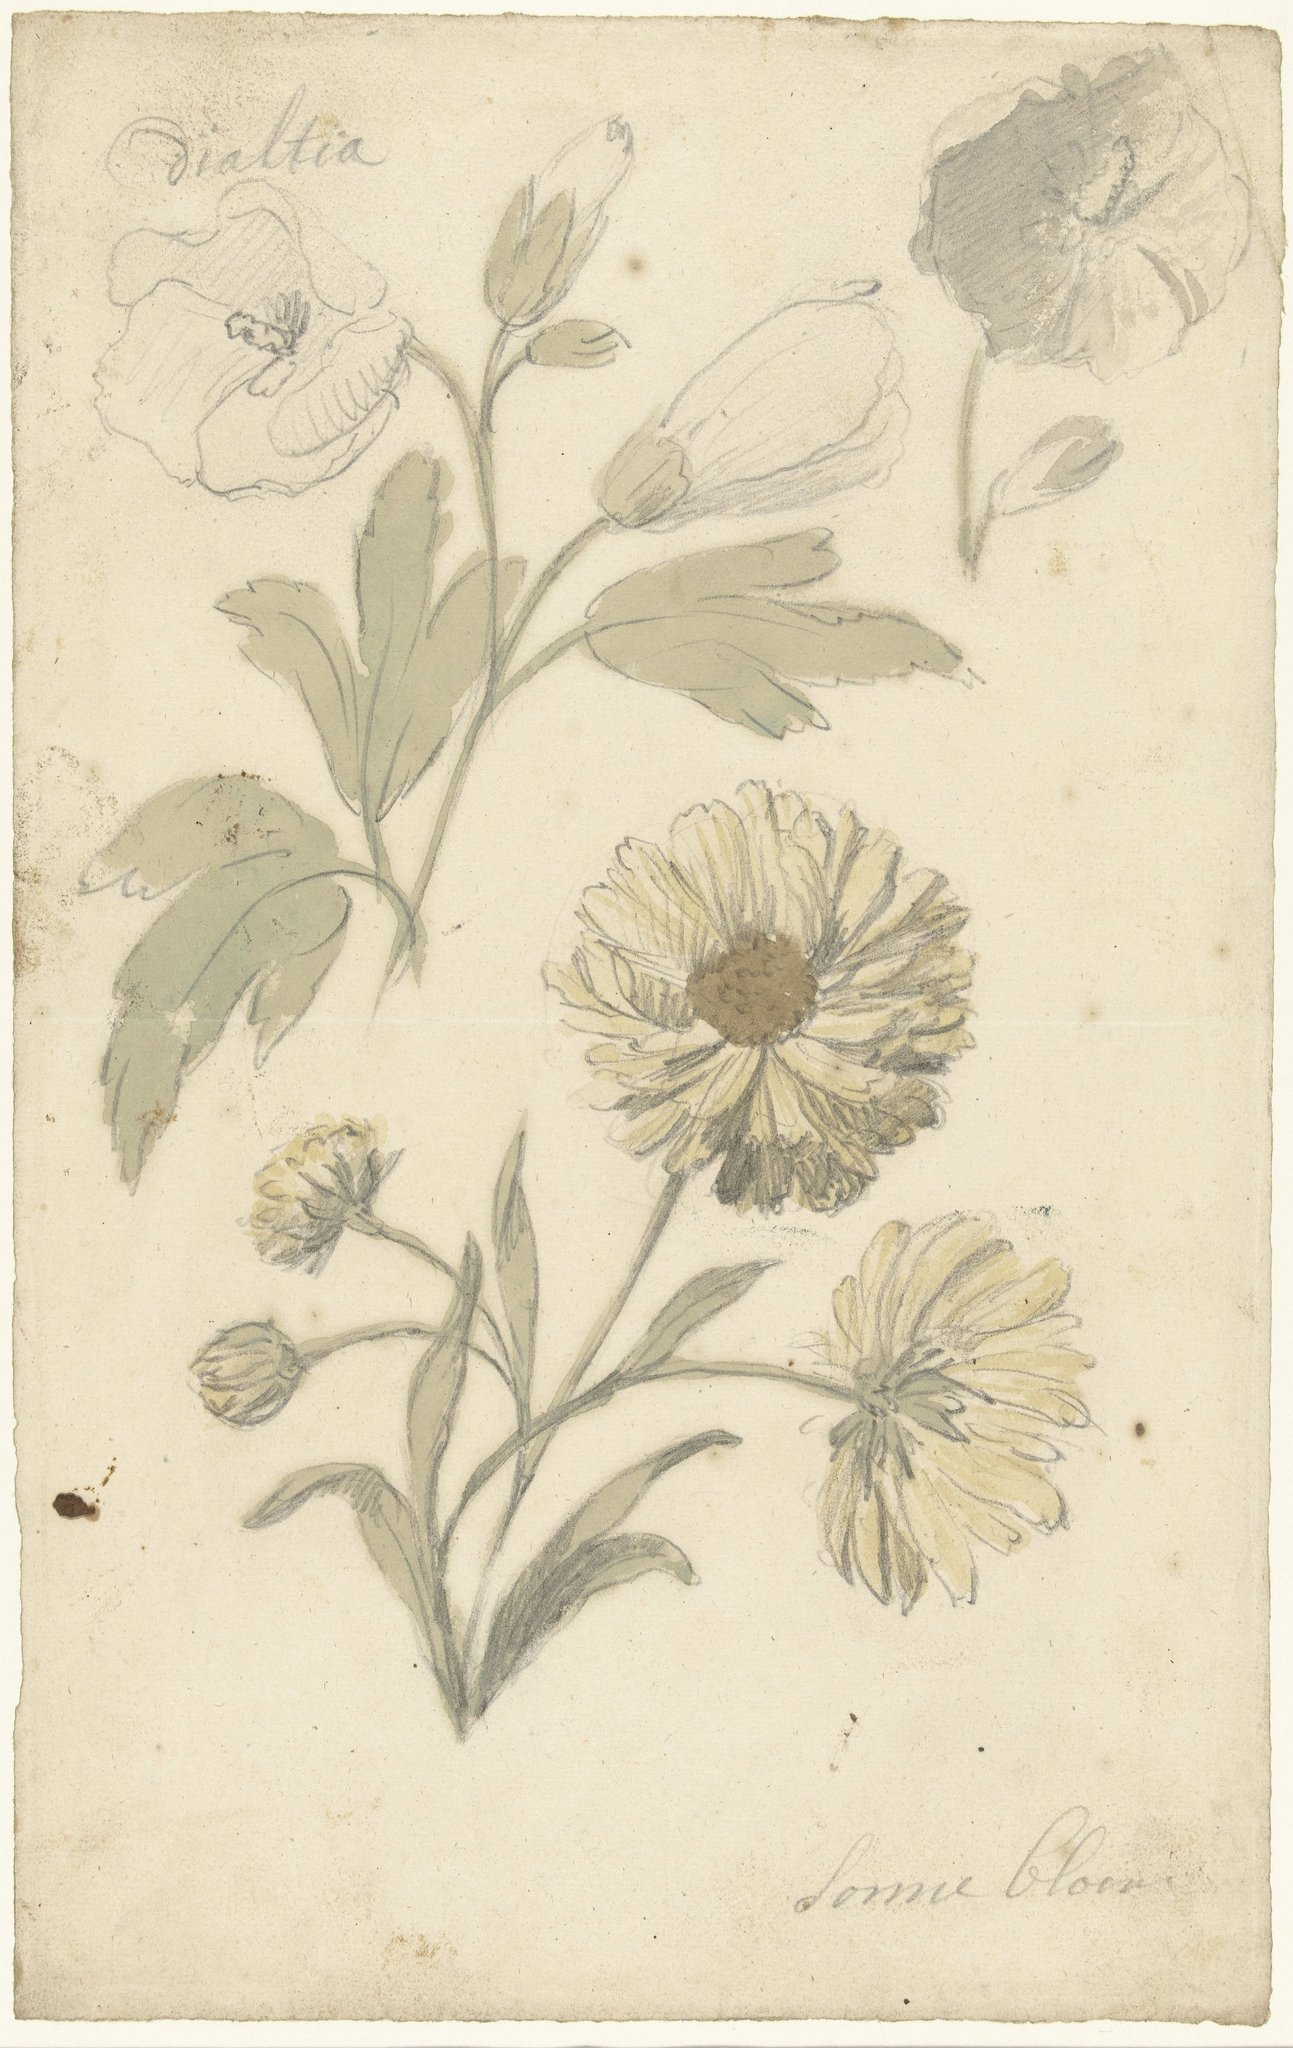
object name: watercolor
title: Studies van zonnebloemen en dialtia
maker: elias van nijmegen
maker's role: draughtsman, painter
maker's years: 1667-1755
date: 1677-1755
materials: paper, pencil, watercolor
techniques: brush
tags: flowers: sunflower